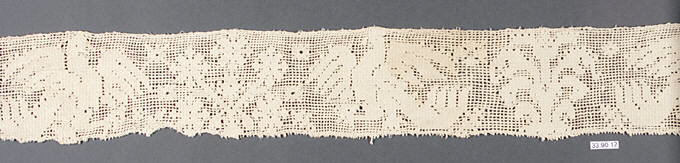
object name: border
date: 1501-1600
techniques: embroidery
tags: birds